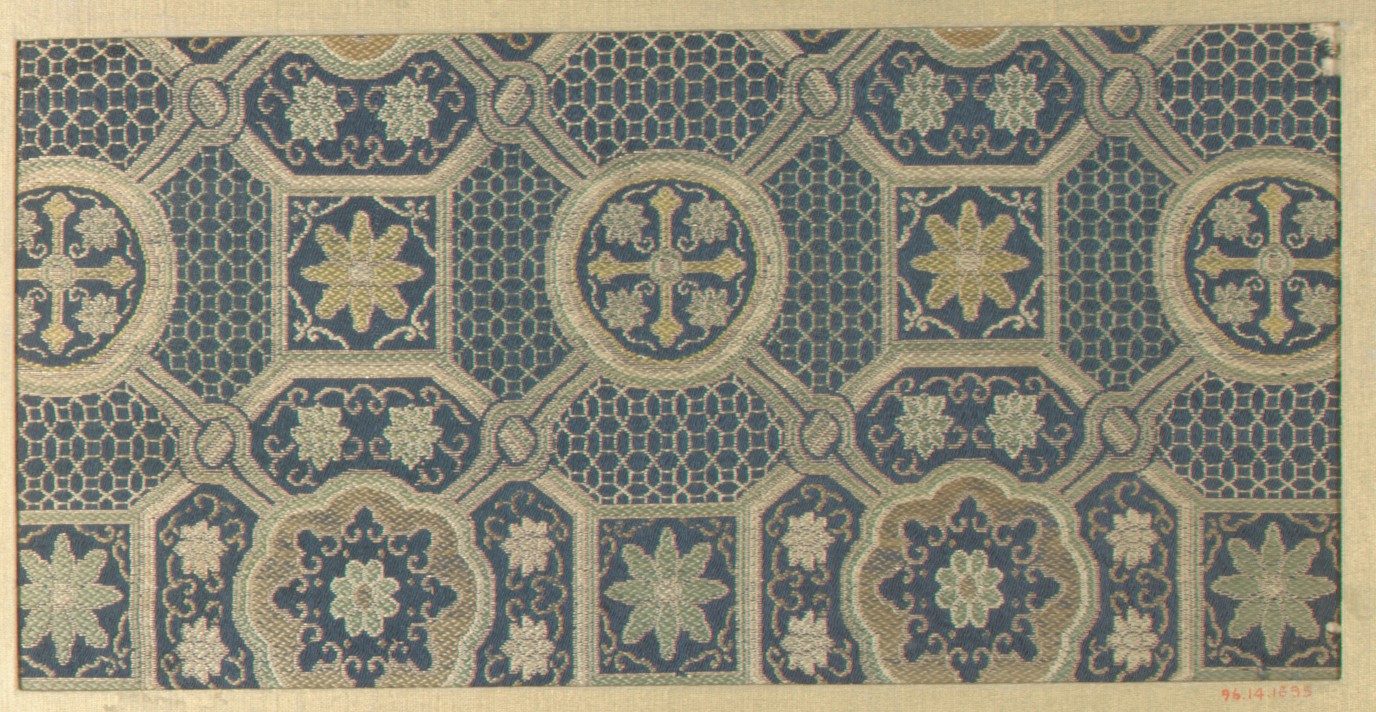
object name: piece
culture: japanese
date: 1701-1900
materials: silk